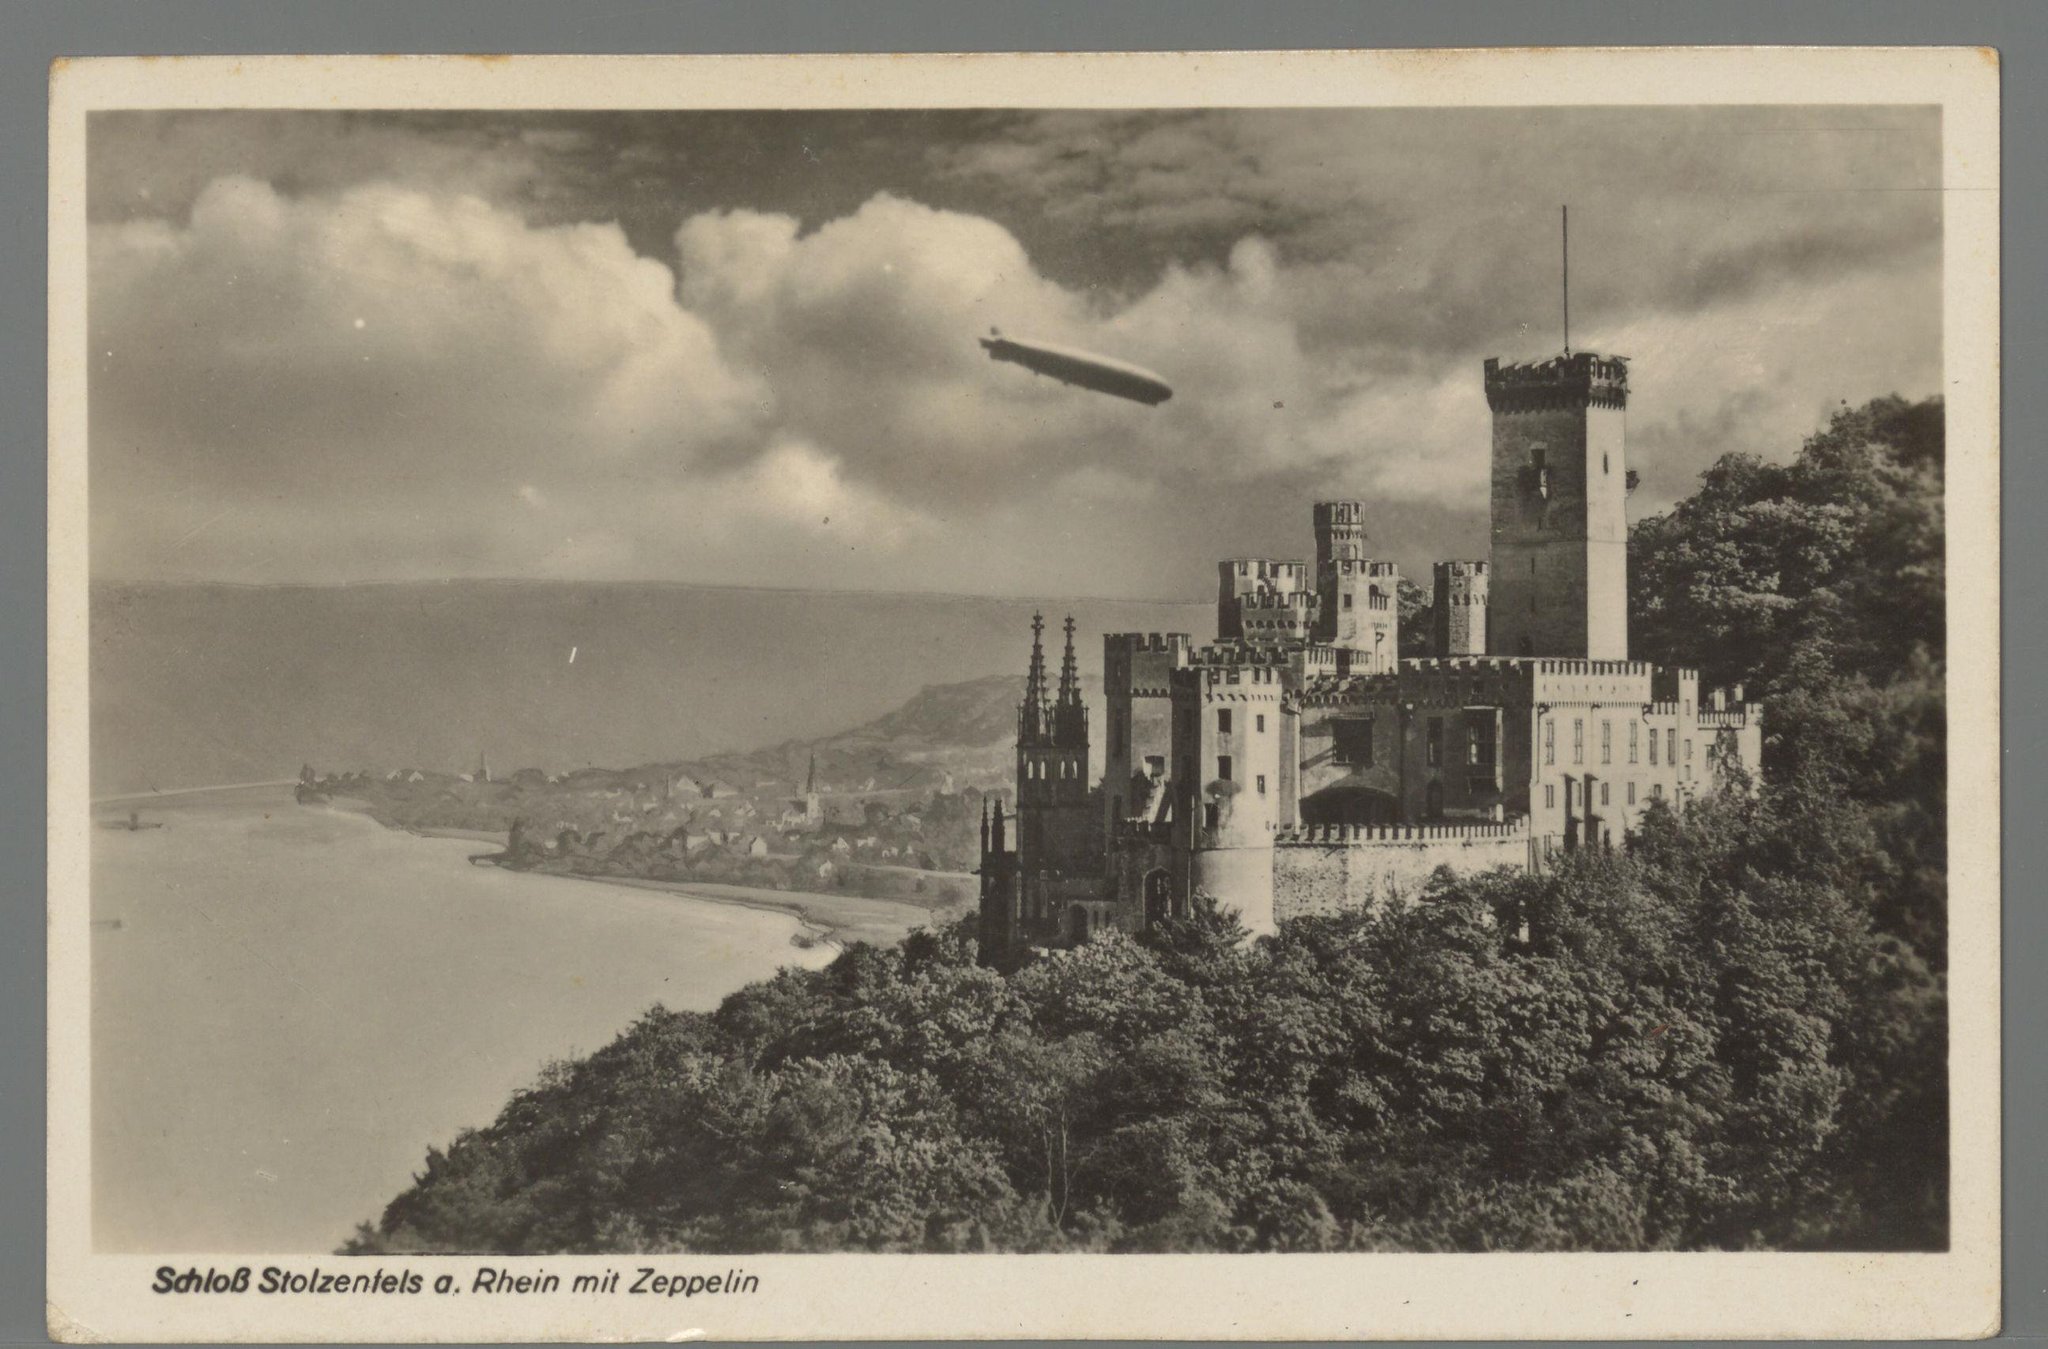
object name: ansichtkaart, prentbriefkaart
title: Schloß Stolzenfels a. Rhein mit Zeppelin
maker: anton hermes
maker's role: publisher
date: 1929-1937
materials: photographic support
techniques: photography, writing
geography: rhineland-palatinate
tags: 46c35 airship, zeppelin, landscape with tower or castle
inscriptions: poststempel, verso, gestempeld